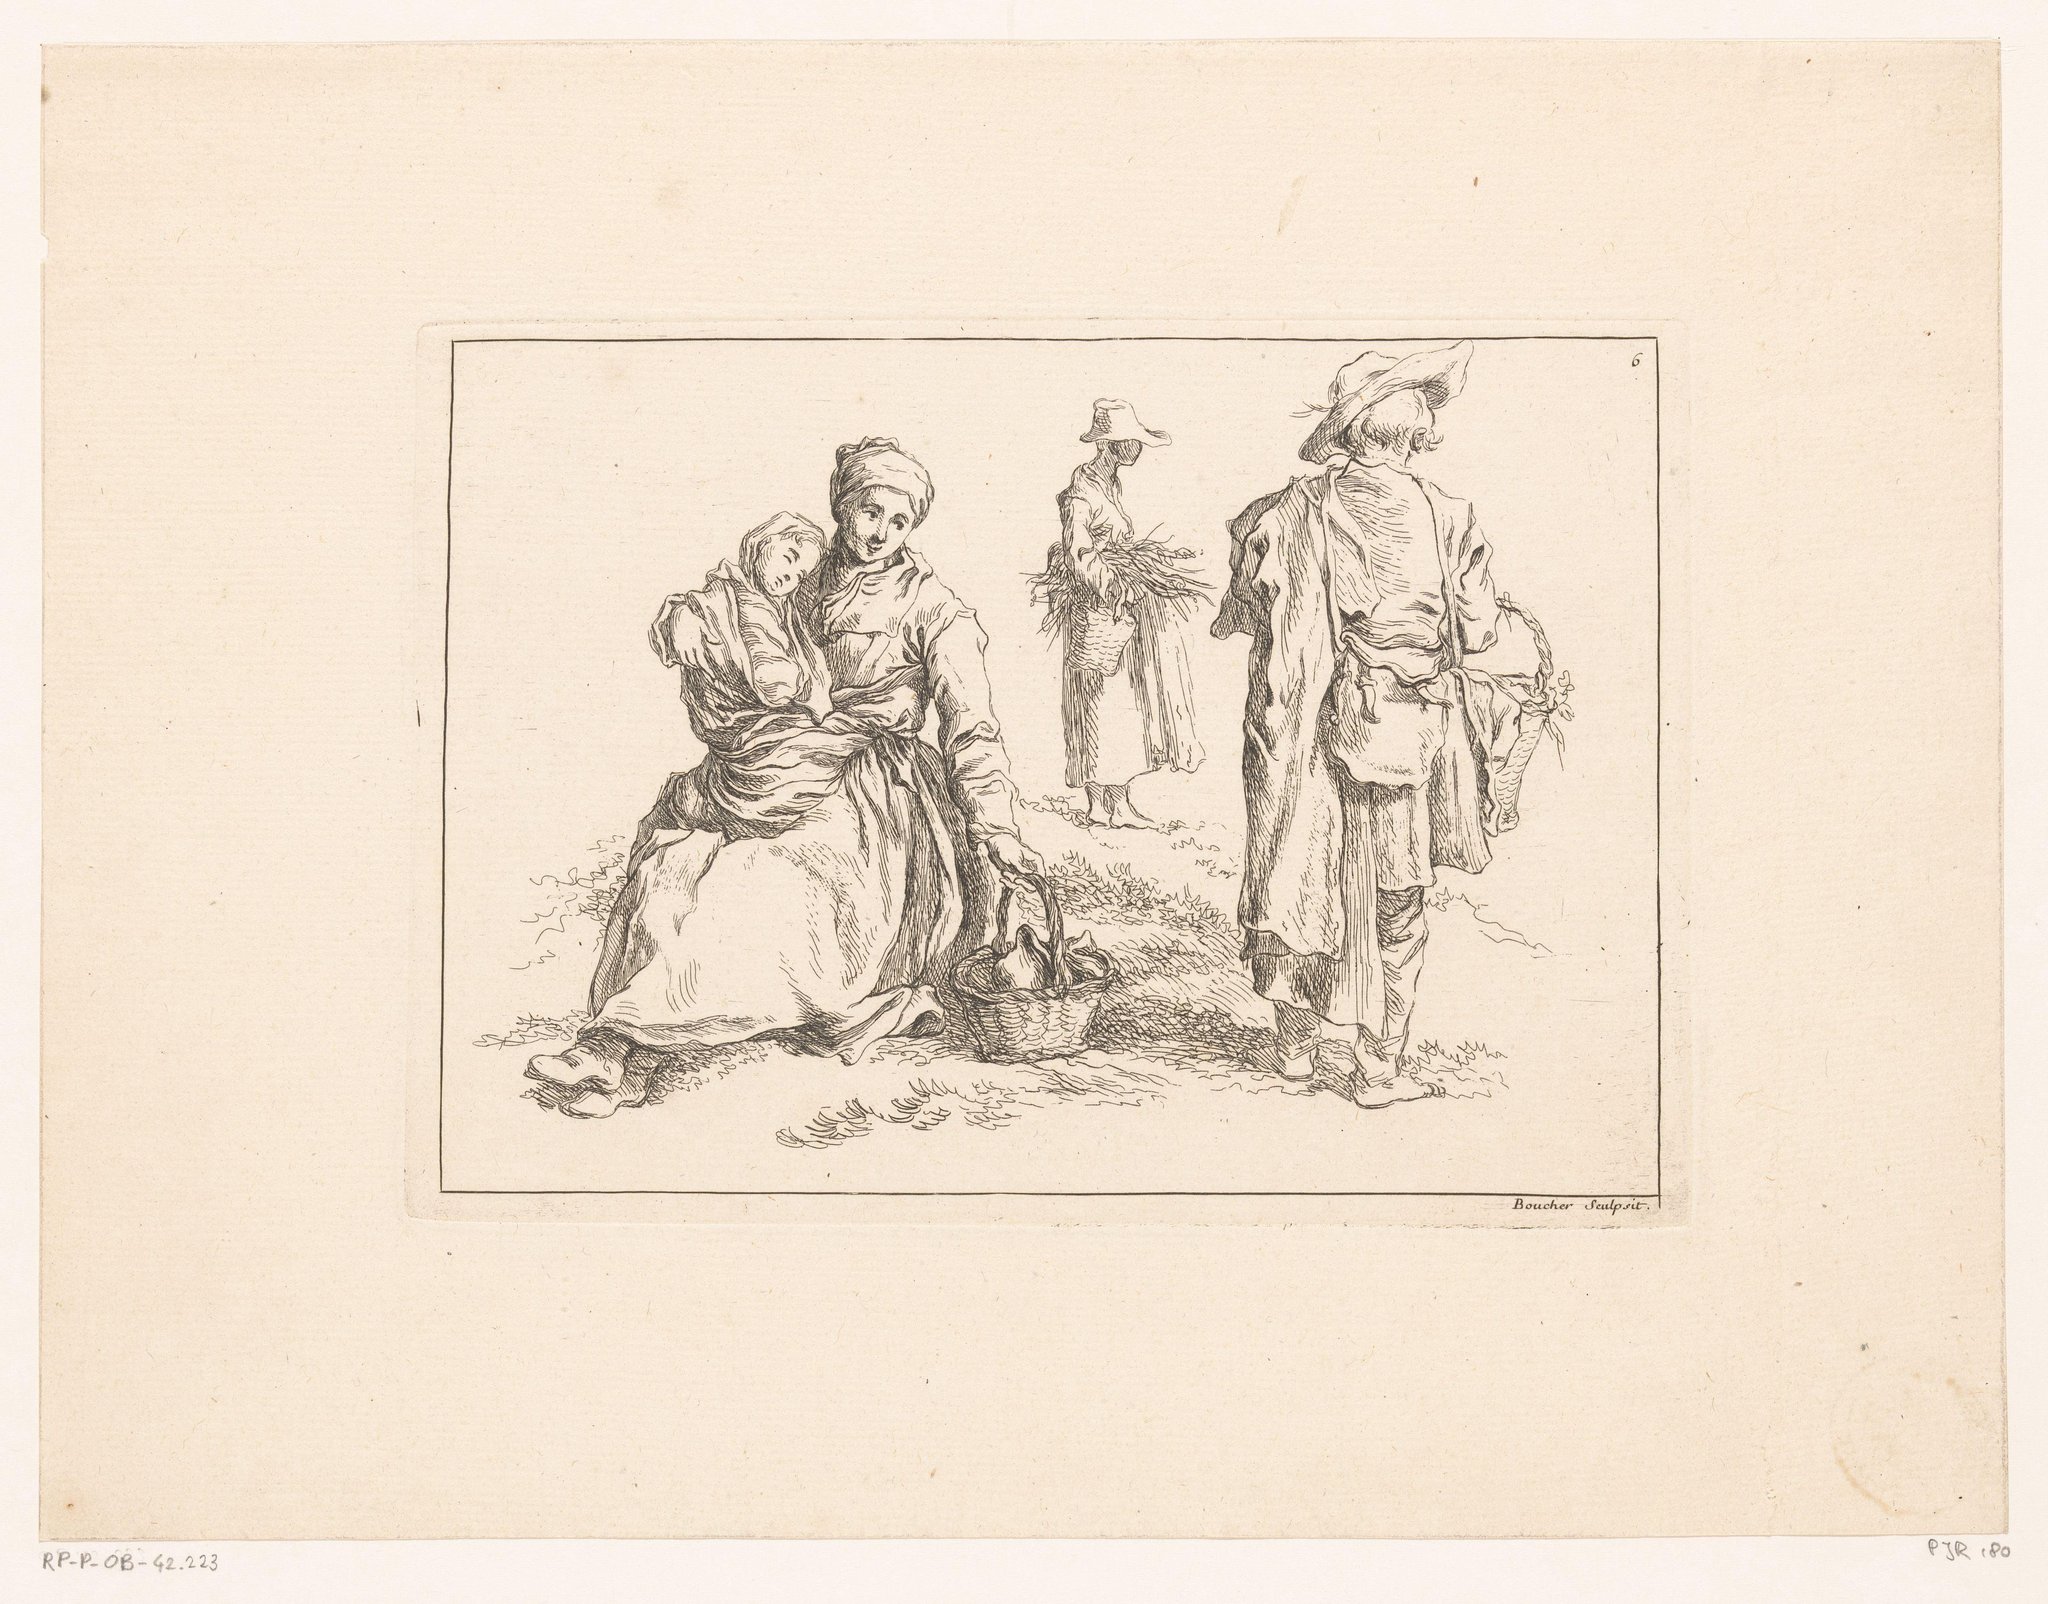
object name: print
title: Vier figuren met links een moeder met kind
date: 1735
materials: paper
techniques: etching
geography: france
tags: sitting figure, container made of plant material other than wood: basket, mother and baby or young child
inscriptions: collector's mark: Lugt 240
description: Maakt deel uit van een serie van twaalf prenten naar tekeningen door Abraham Bloemaert, getiteld 'Livre d'Etude d'après les Desseins Originaux de Blomart'.